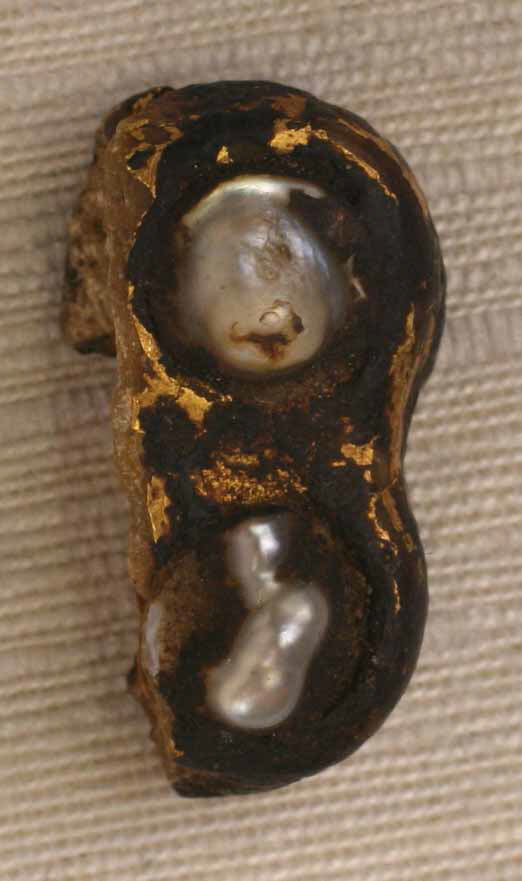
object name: plaque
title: Plaque for a Collar or Necklace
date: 701-800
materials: gold, mother of pearl, stone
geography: egypt